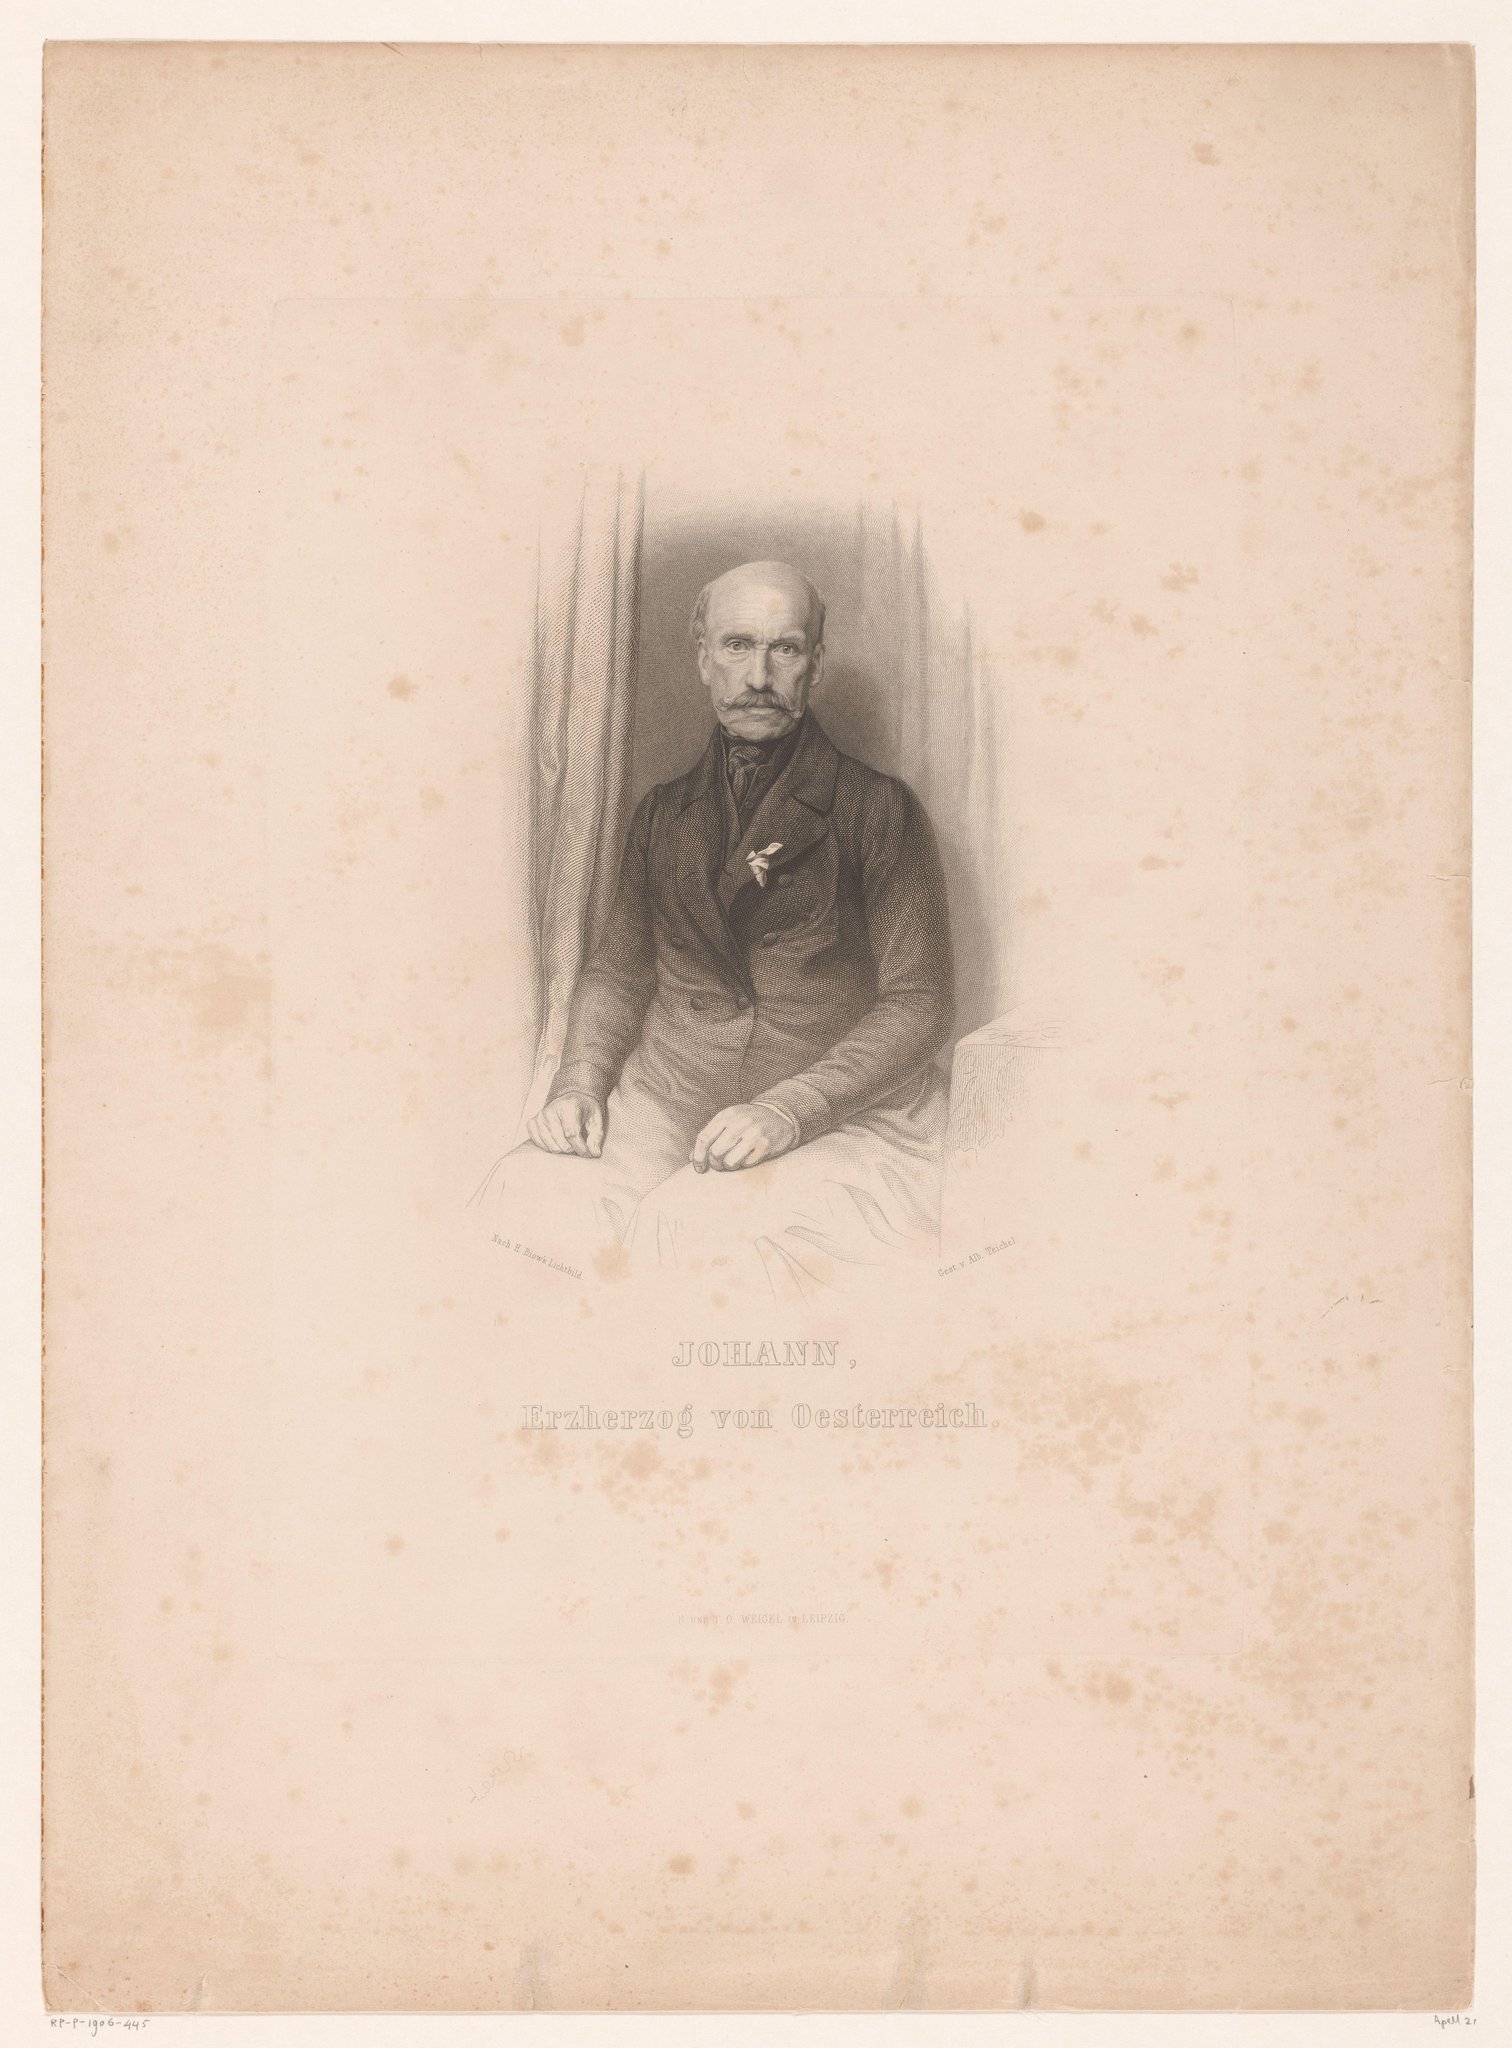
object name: print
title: Portret van Johann, aartshertog van Oostenrijk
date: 1832-1873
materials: paper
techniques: engraving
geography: leipzig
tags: historical persons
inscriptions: collector's mark: Lugt 2228